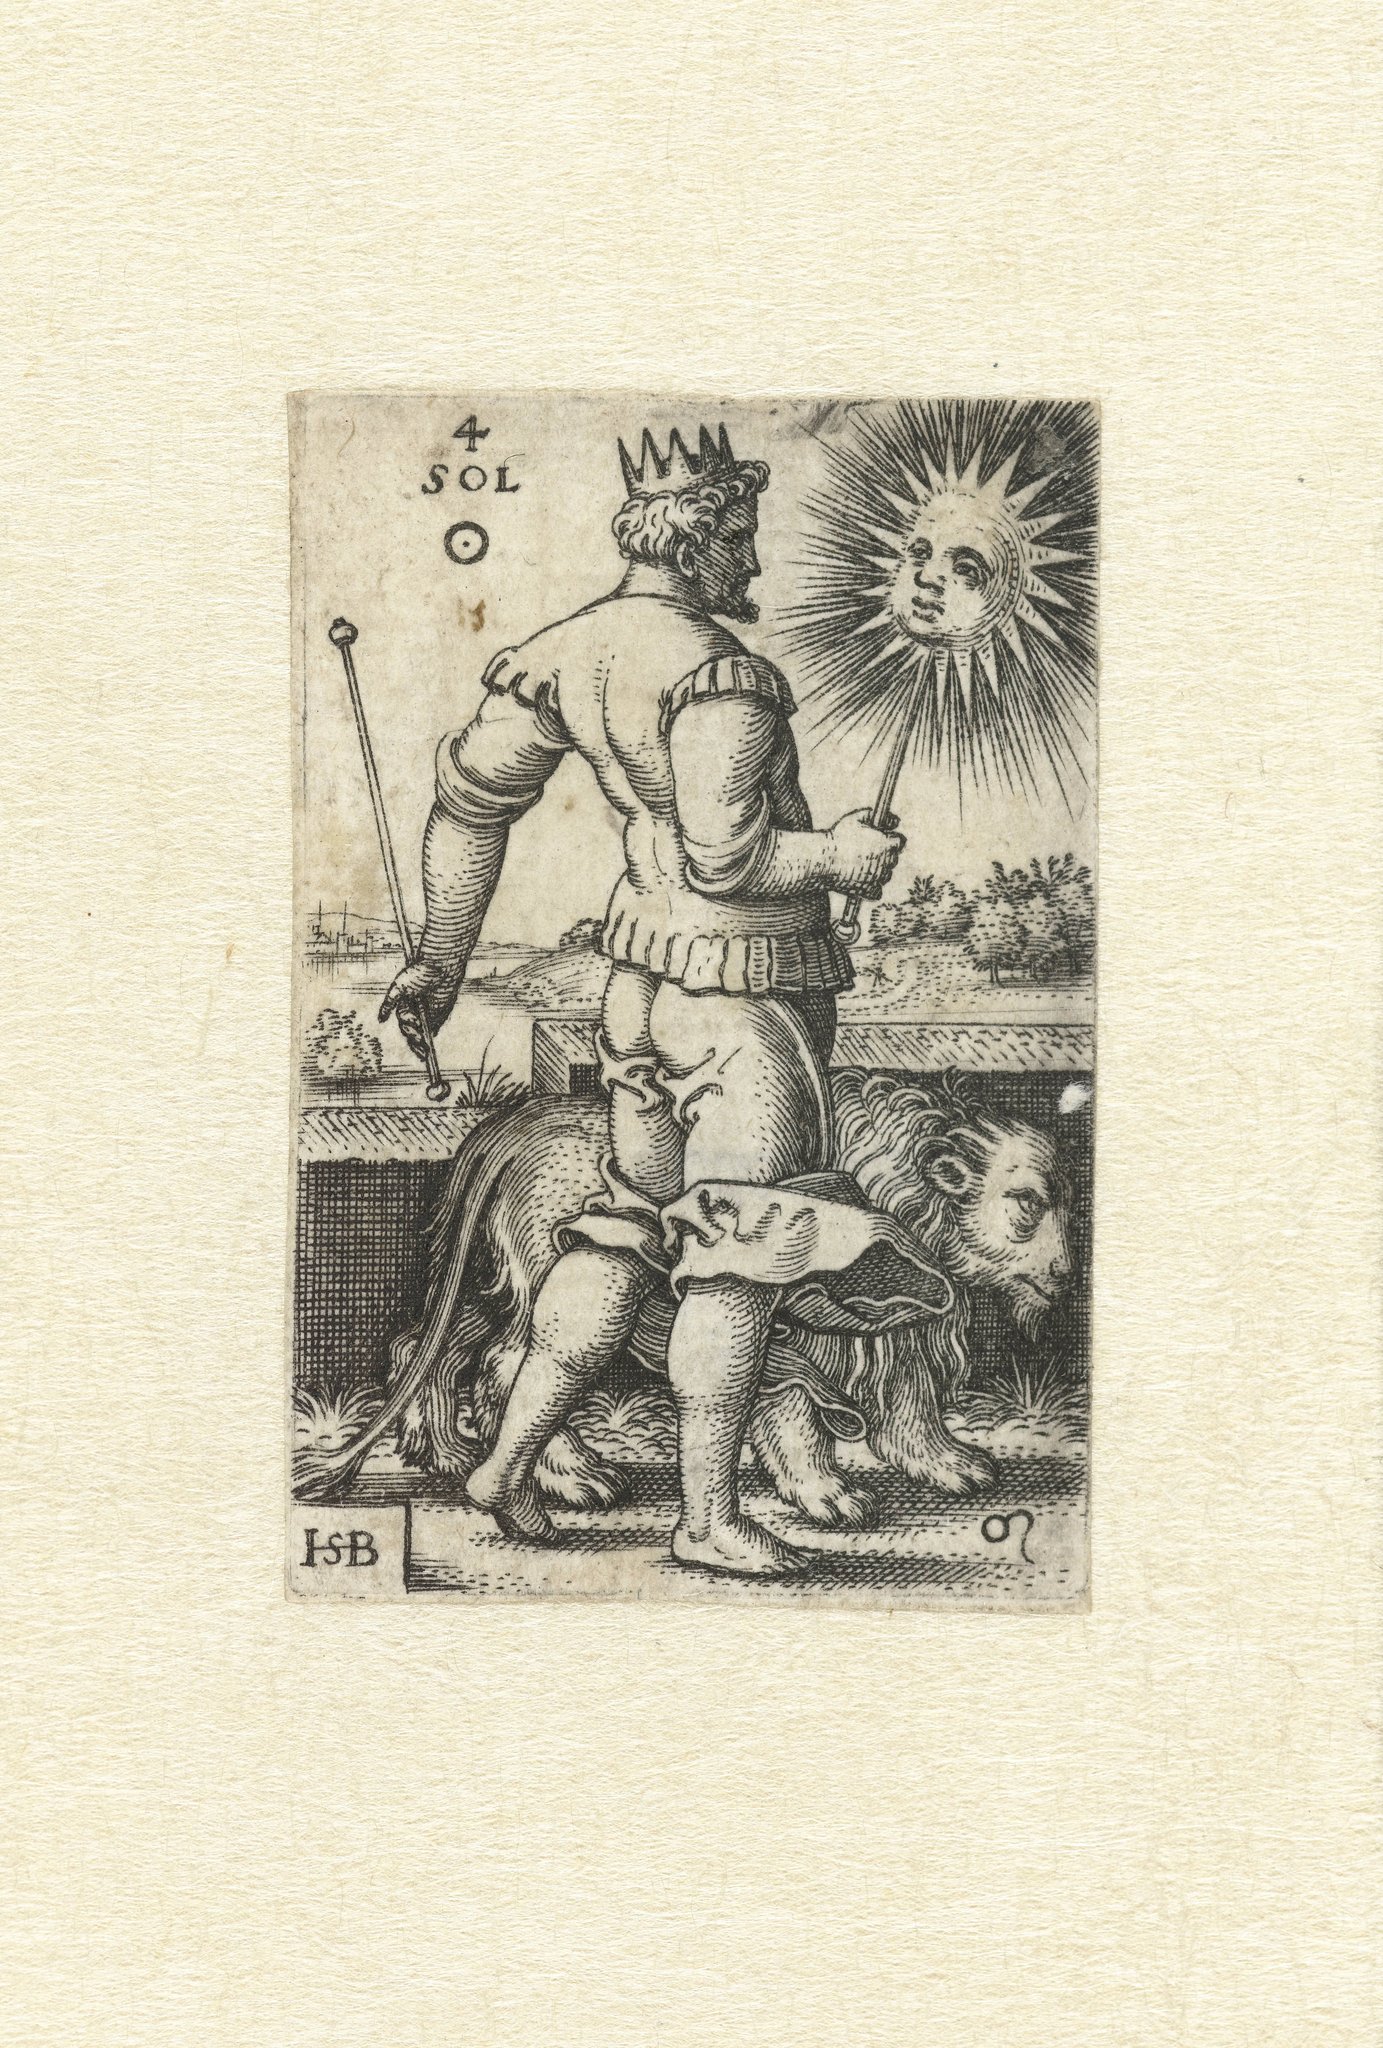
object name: print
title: Apollo (Sol) met sterrenbeeld Leeuw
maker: hans sebald beham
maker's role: designer, draughtsman, print maker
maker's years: 1500-1550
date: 1539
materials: paper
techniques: engraving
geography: frankfurt am main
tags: sol and his children ('planetenkinder') ~ leo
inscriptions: collector's mark: ‘Hinloopen’ Lugt 11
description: Zonnegod Apollo (Sol) als personificatie van de Zon met zijn planetenkind het sterrenbeeld Leeuw